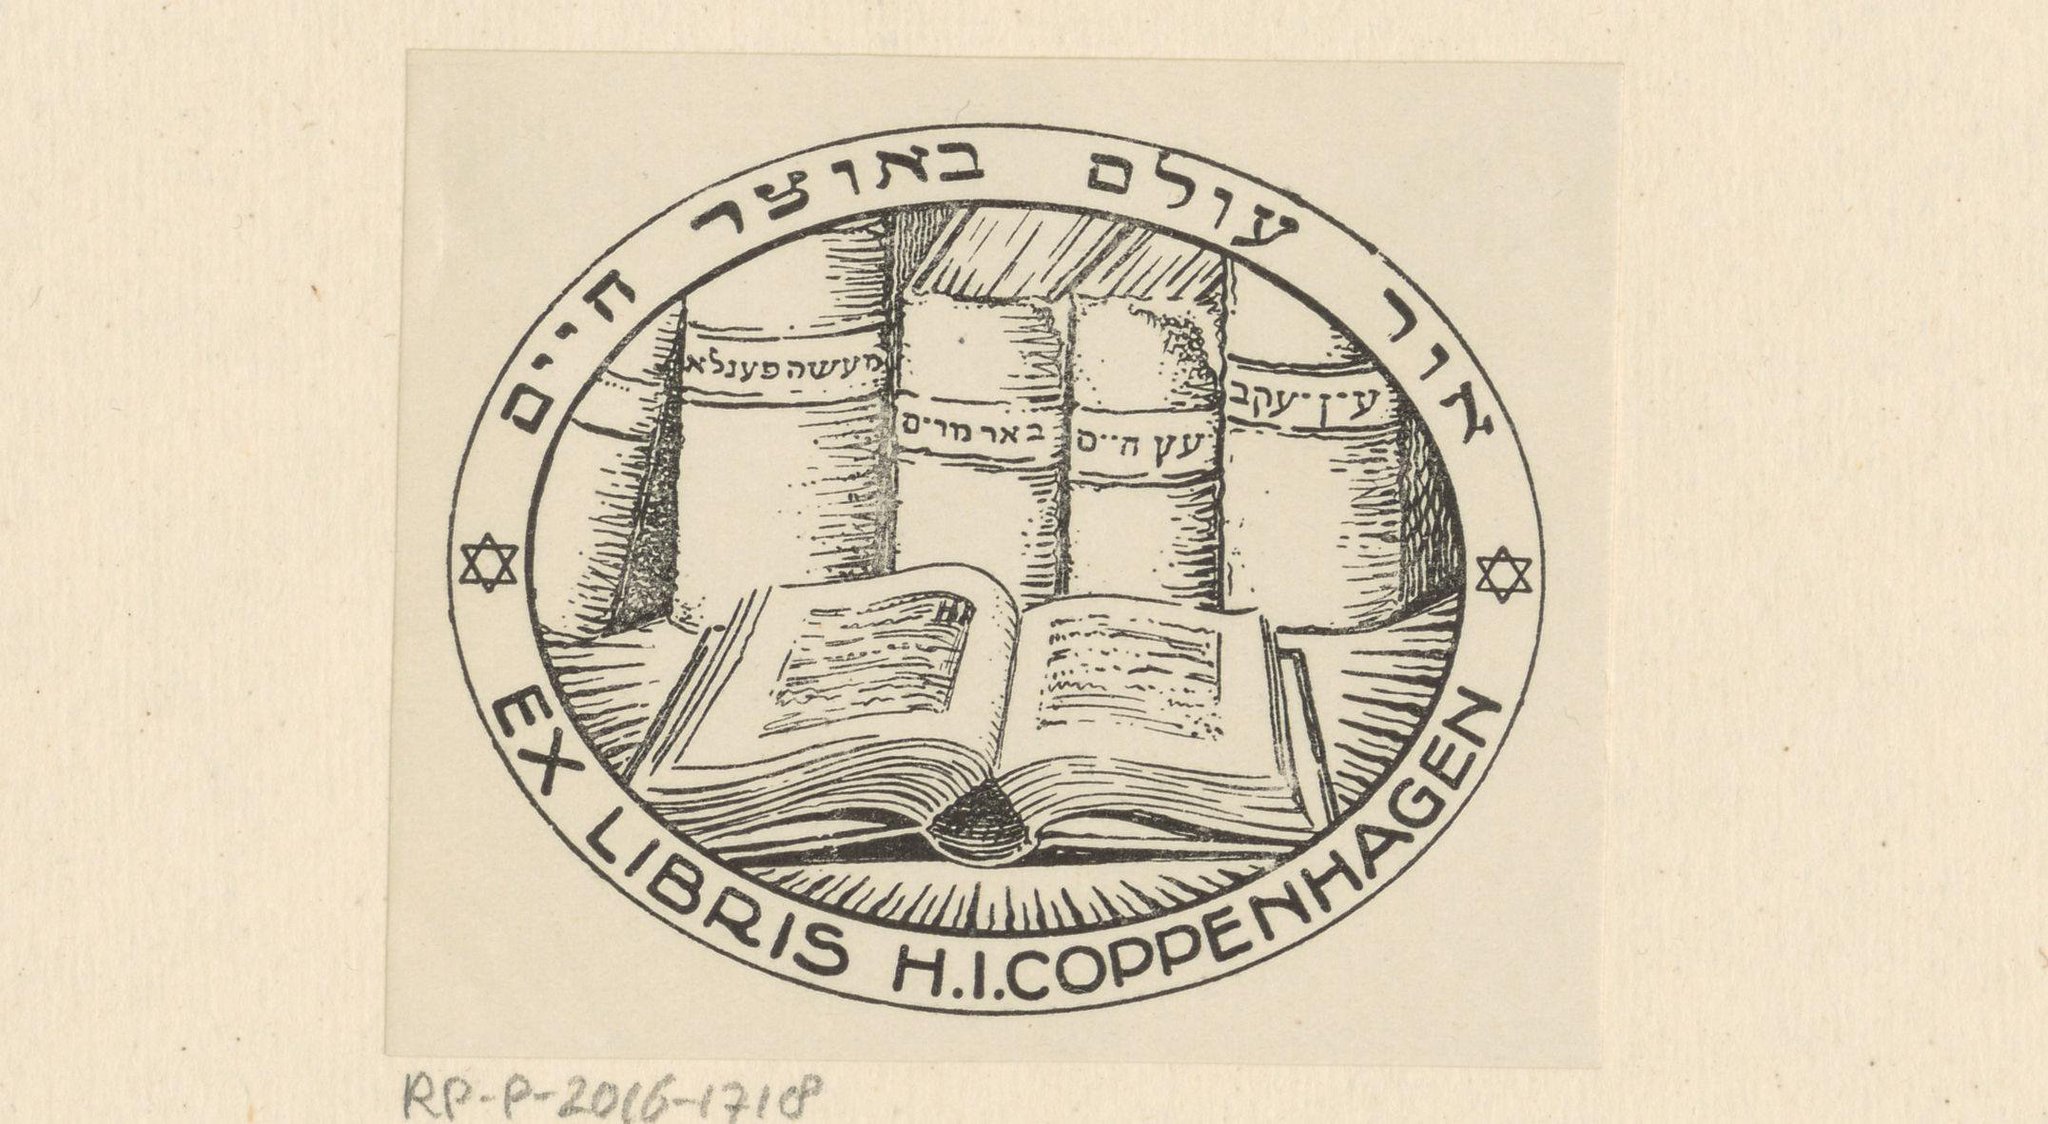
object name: bookplate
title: אור עולם באוער תיים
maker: dirk gerardus schnabel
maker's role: clichémaker, fotograaf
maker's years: 1870-1933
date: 1930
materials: paper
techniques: printing block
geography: netherlands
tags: religious and magic concepts, occupations, fashions, realities, general ideas ~ judaism and jewry, book - mm - book open